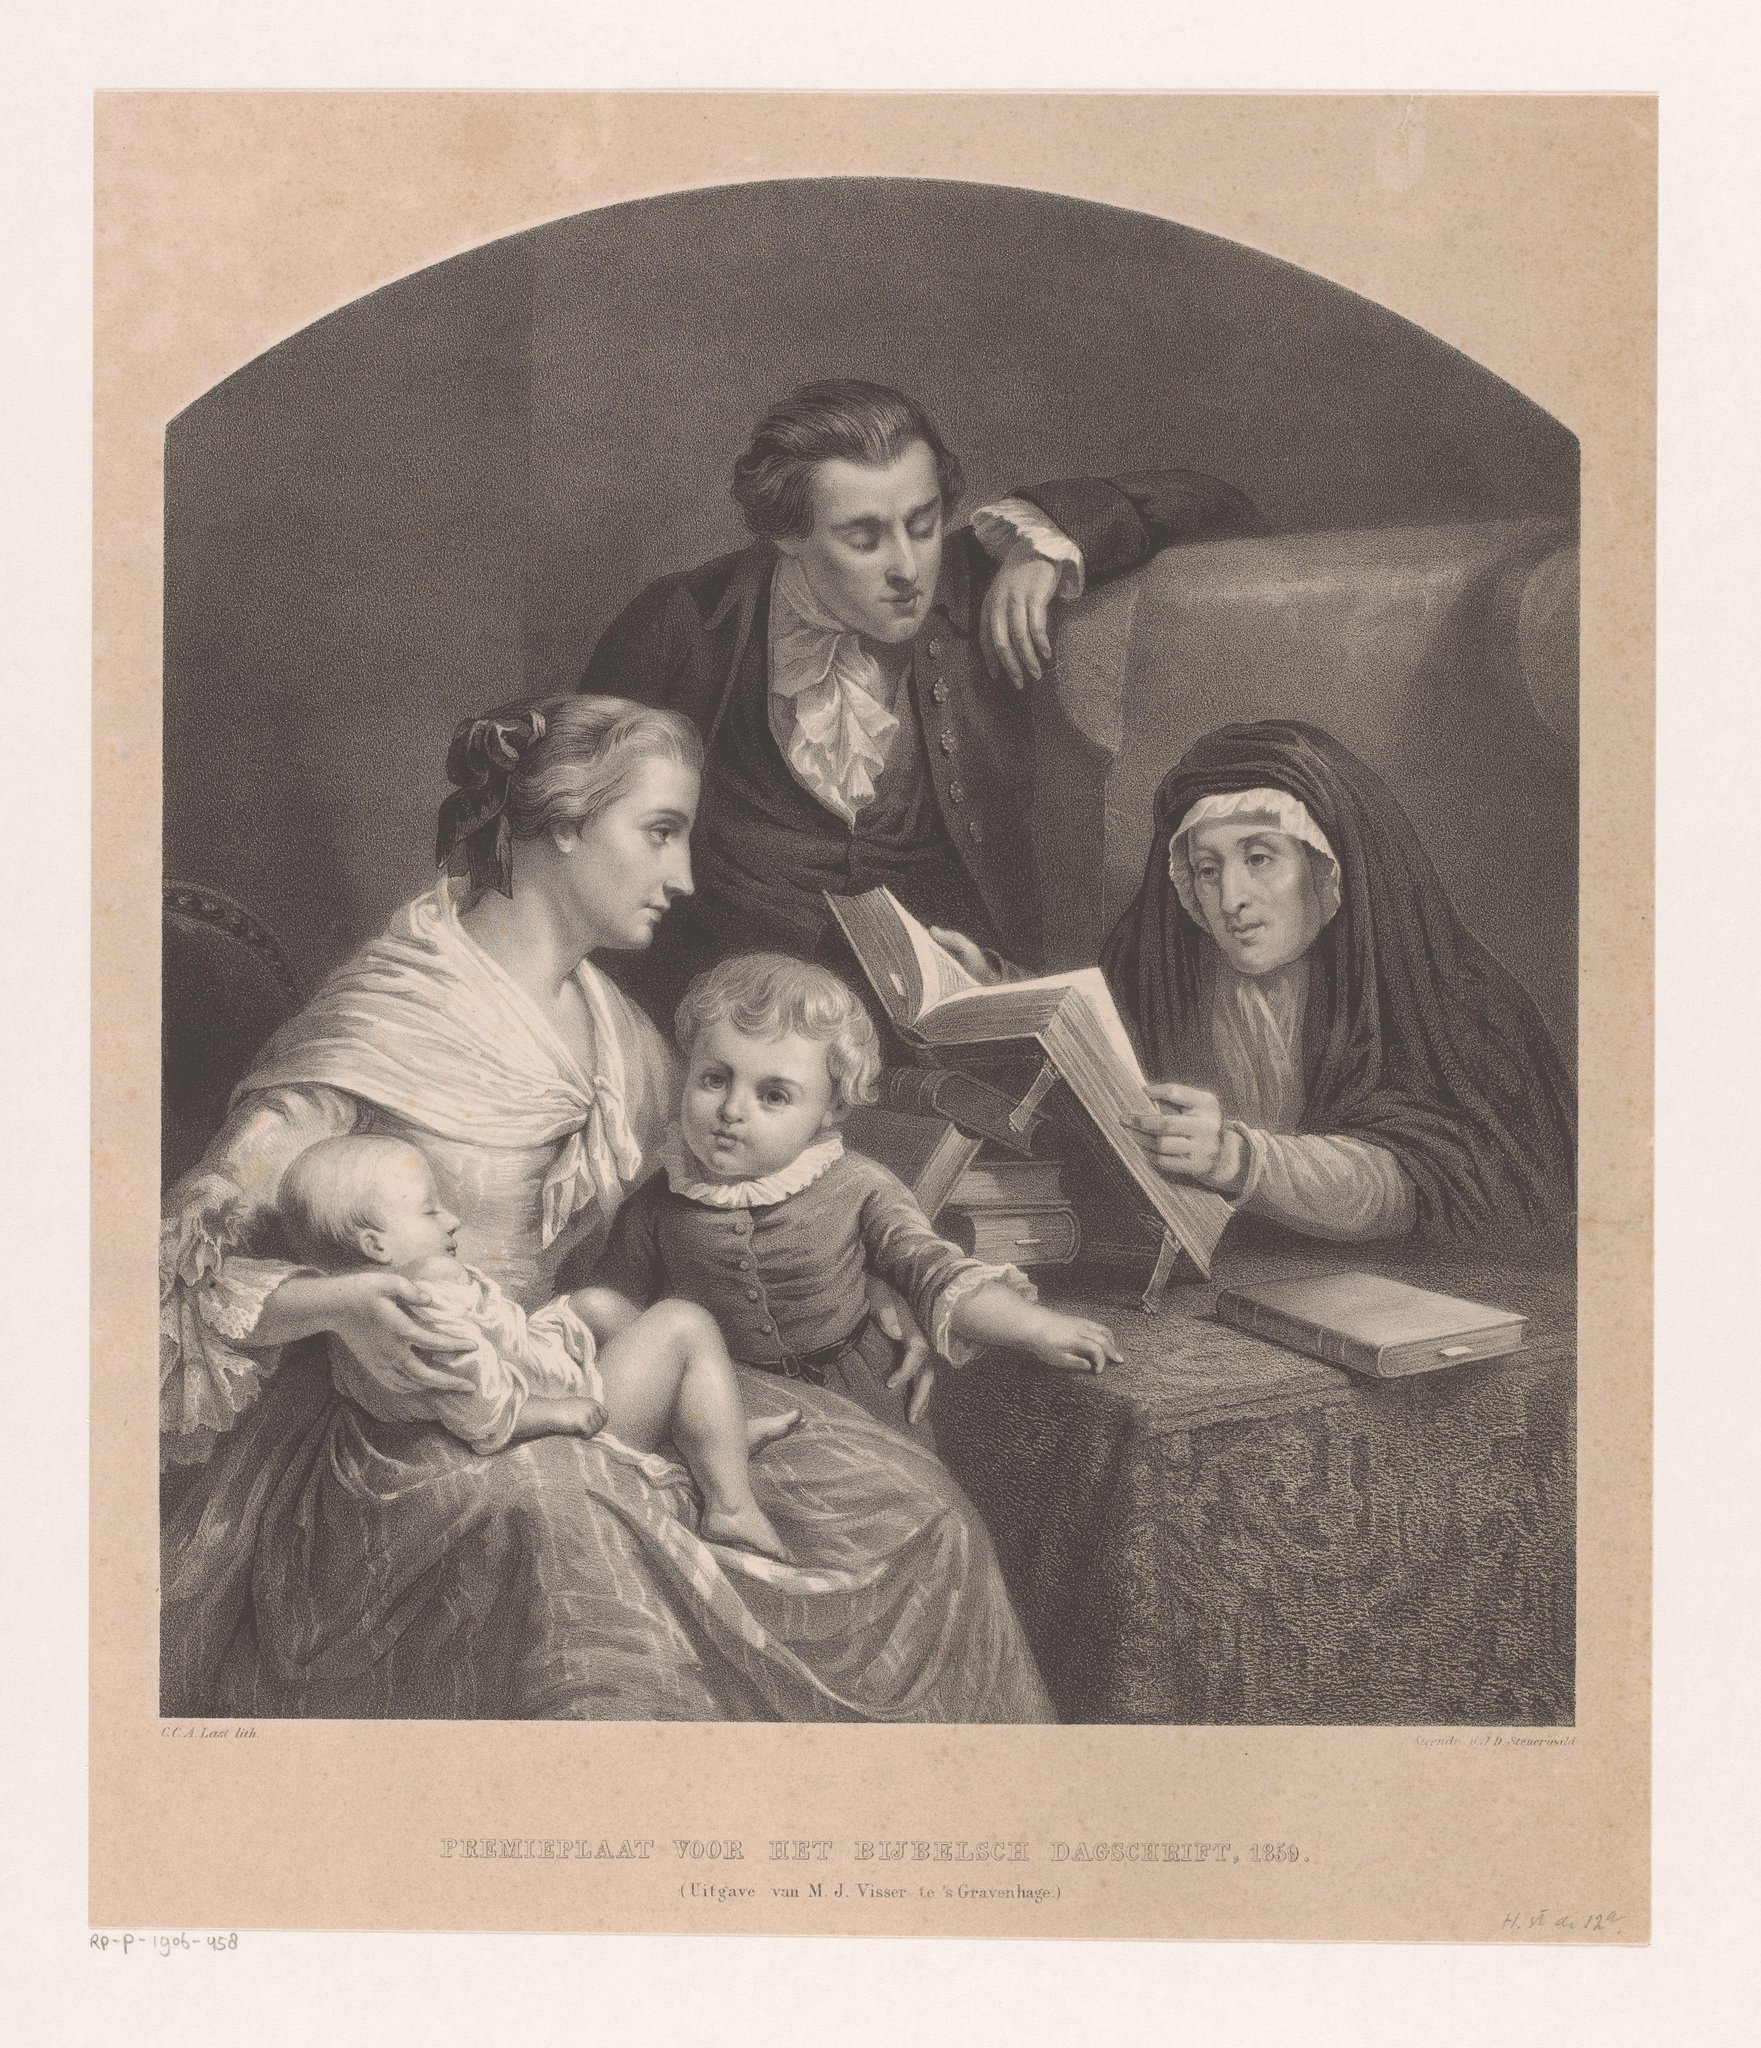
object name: print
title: Oude vrouw leest voor aan gezin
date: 1859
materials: paper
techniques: lithograph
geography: the hague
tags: family group, especially parents with their child(ren), reading the bible or other religious books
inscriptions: collector's mark: Lugt 2228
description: De vrouw heeft een stapel boeken voor zich en leest voor, mogelijk uit de Bijbel. Voor haar zit een vrouw met twee kinderen. De vader van het gezin leunt over de stoel van de oude vrouw en leest mee.